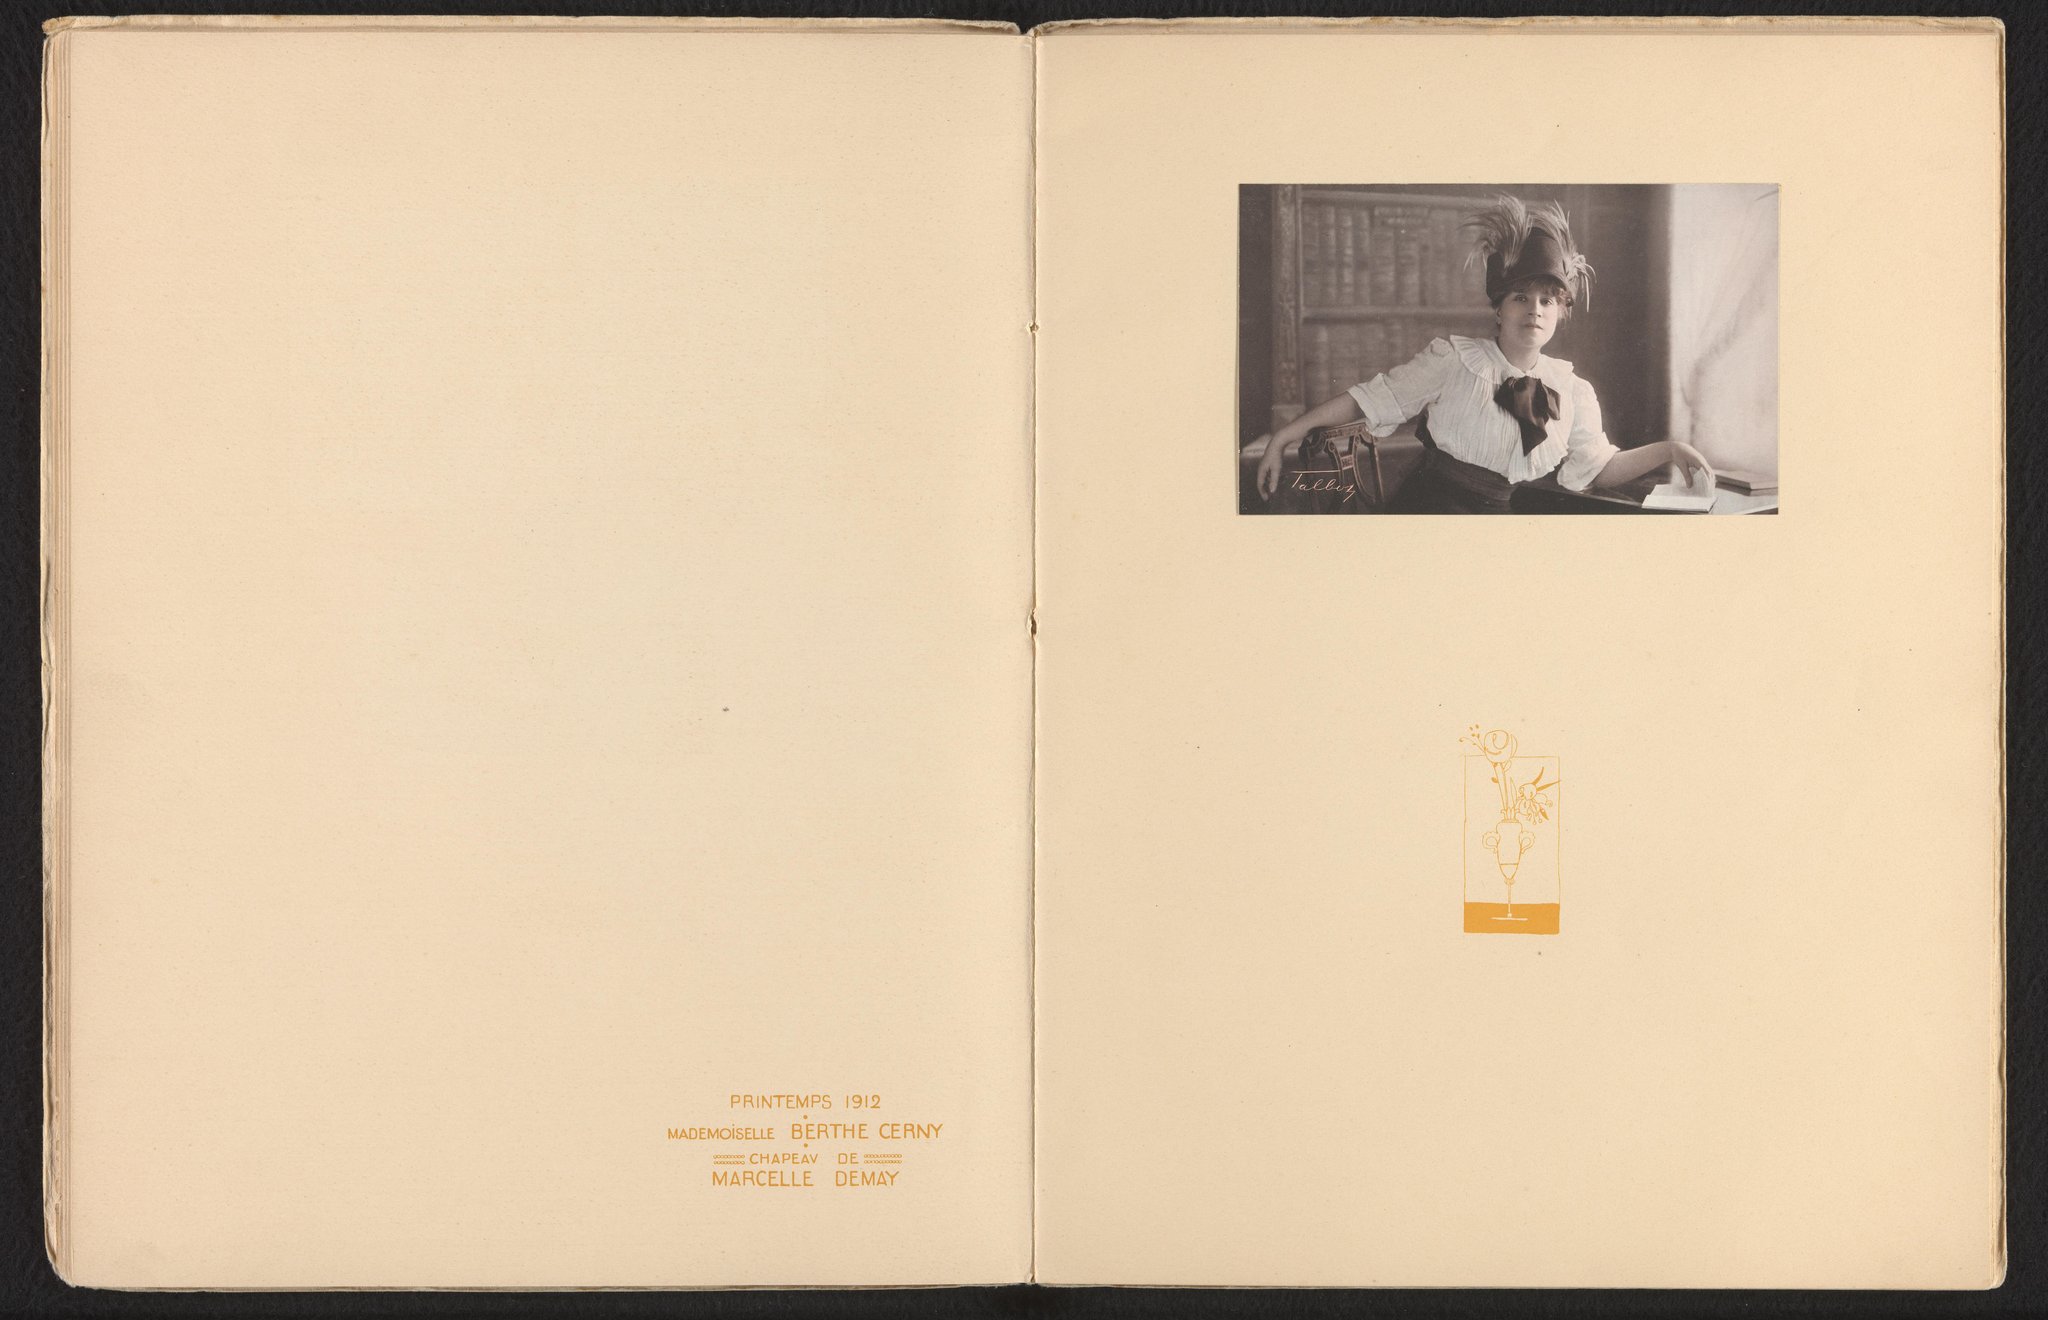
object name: photomechanical print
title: Portret van Berthe Cerny met hoed door Marcelle Demay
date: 1907-1912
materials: paper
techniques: two-color autotype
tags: paris, historical persons - bb - woman